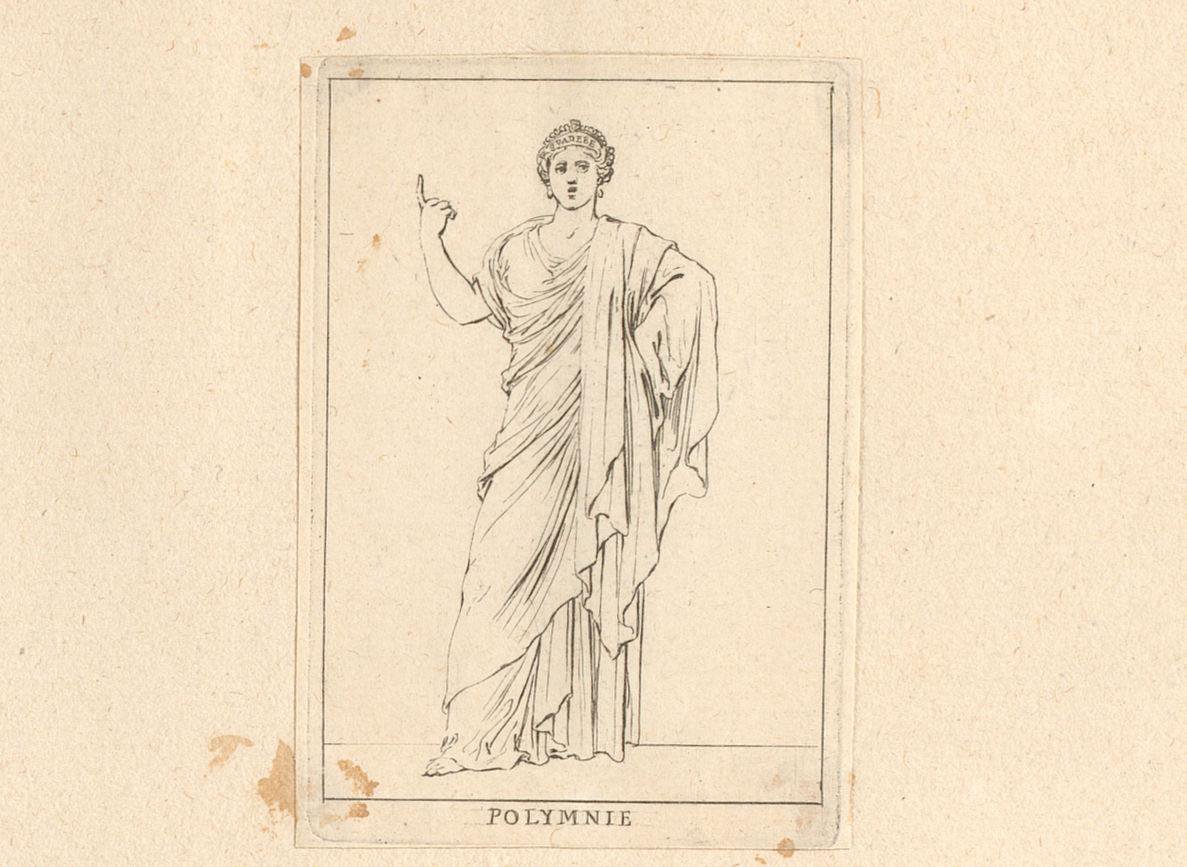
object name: print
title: Verschillende muzen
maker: sébastien leclerc (i)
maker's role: print maker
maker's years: 1637-1714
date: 1647-1714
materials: paper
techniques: etching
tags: polyhymnia (one of the muses); 'polinnia' (ripa)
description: Prent maakt mogelijk deel uit van een serie met verschillende muzen.